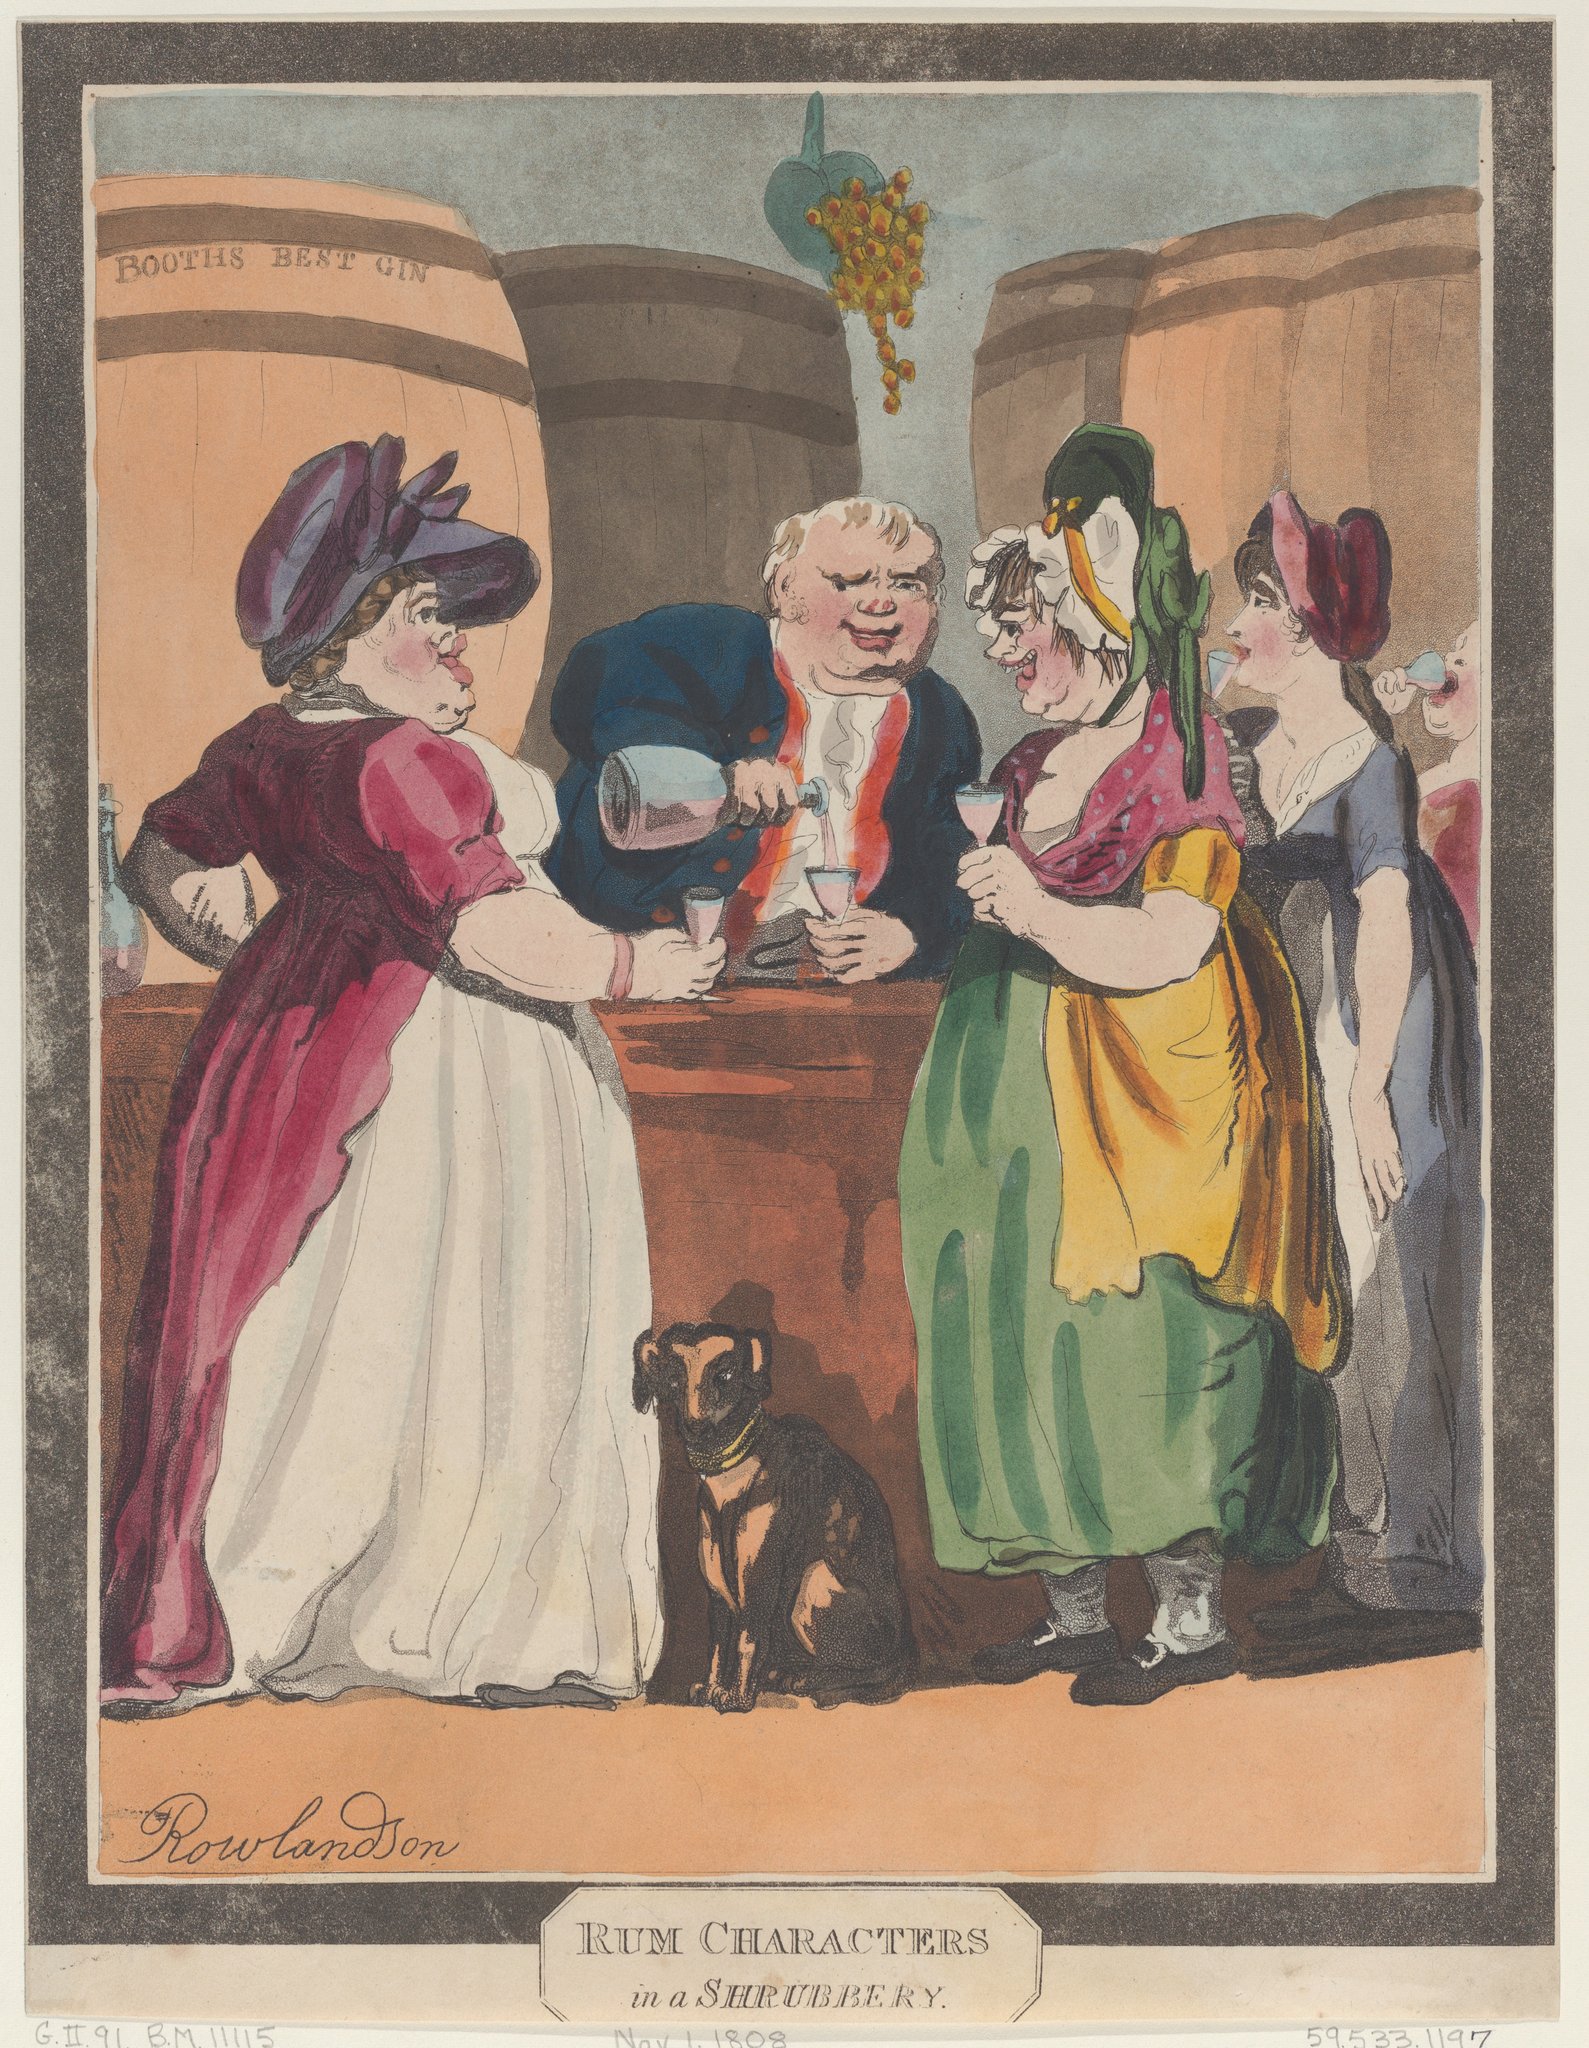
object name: print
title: Rum Characters in a Shrubbery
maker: thomas rowlandson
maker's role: artist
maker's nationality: british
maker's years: 1757-1827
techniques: aquatint, etching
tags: satire,men,women,dogs,drinking